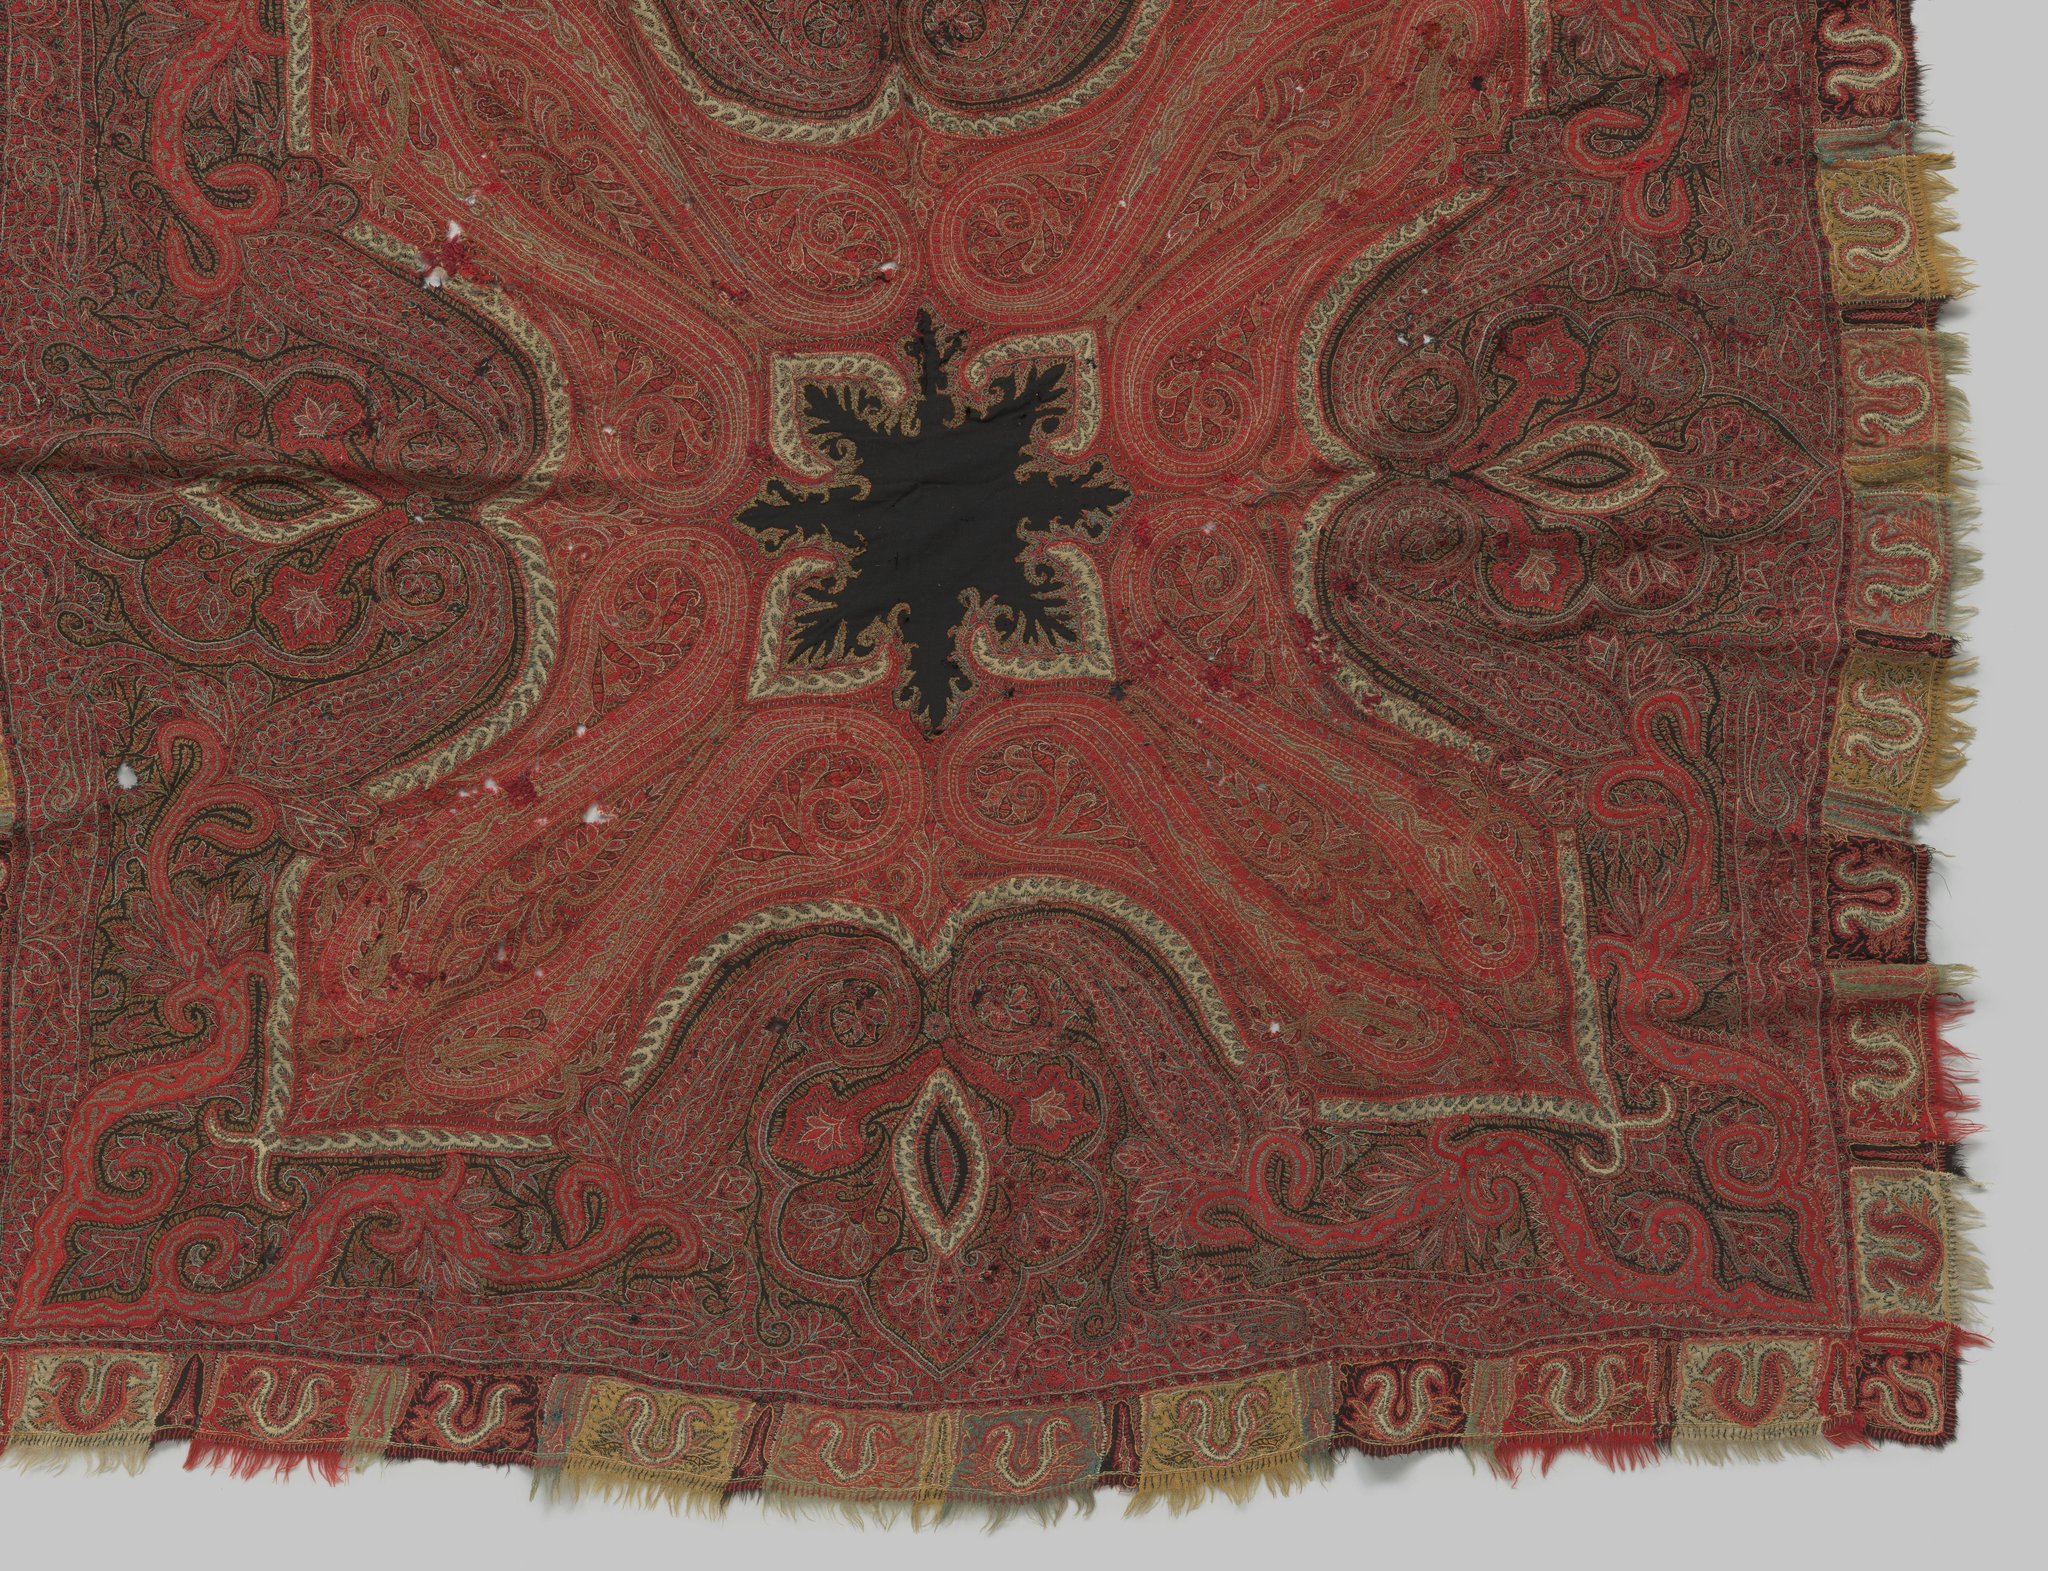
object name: clothing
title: Bijna vierkante kasjmiersjaal van veelkleurig wollen borduursel op een ondergrond, die is ingelegd en geappliceerd met rode, zwarte en witte wollen stof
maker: Anonymous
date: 1850-1875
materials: wool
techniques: embroidered, weave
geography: kashmir